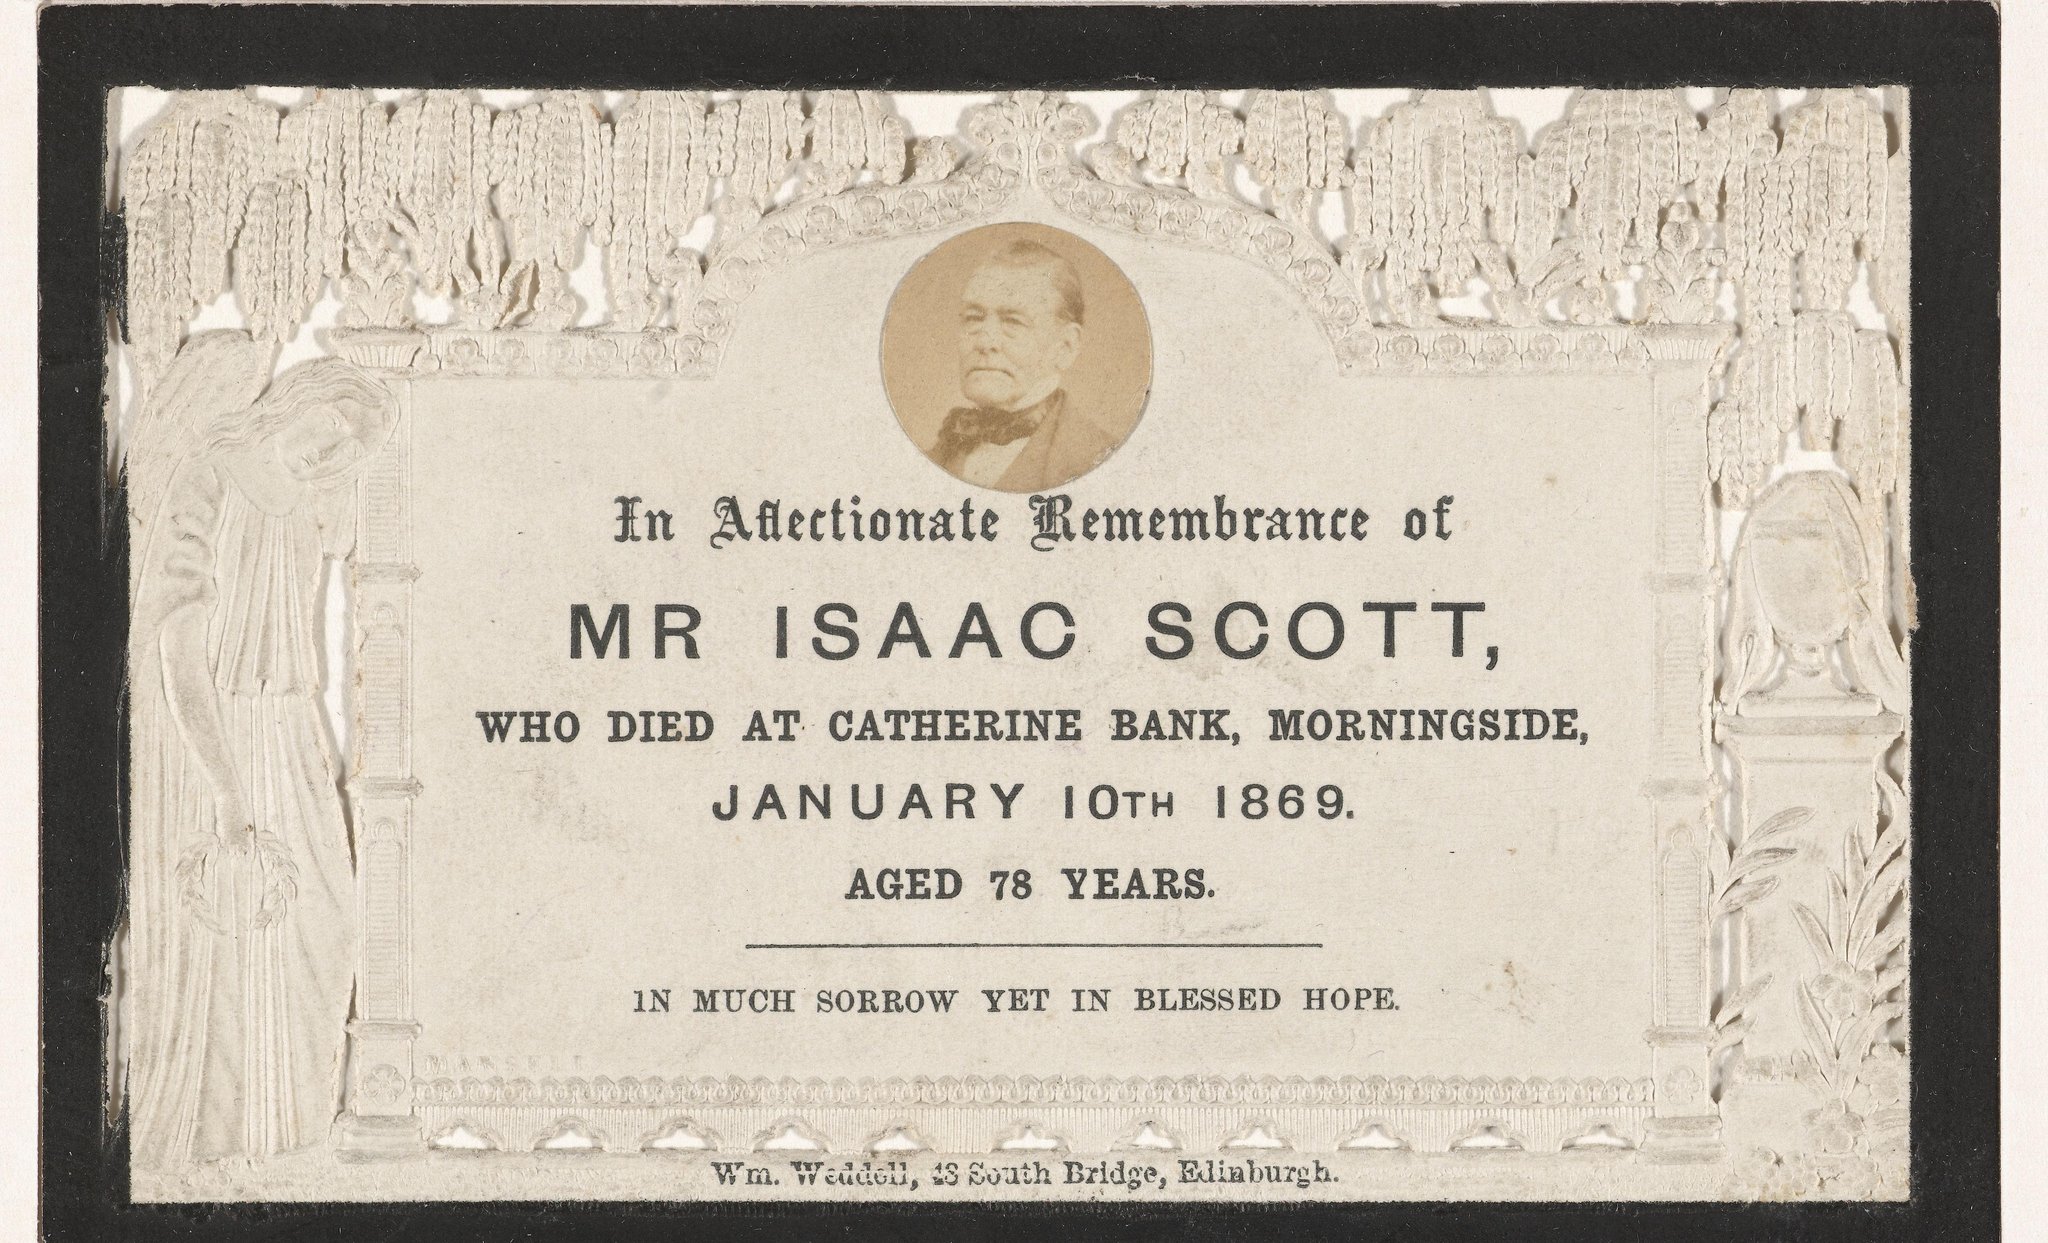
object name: photograph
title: Portret van Isaac Scott op zijn overlijdenskaart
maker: Anonymous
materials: cardboard, paper, photographic support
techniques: albumen print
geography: scotland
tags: mourning card, death notice, obituary, historical persons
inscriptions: inscription: ‘In Affectionate Remembrance of/ Mr Isaac Scott,/ who died at Catherine Bank, Morningside,/ JANUARY 10th 1869./ AgGED 78 YEARS./ IN MUCH SORROW YET IN BLESSED HOPE./ Wm. Weddell, 48 South Bridge, Edinburgh.’